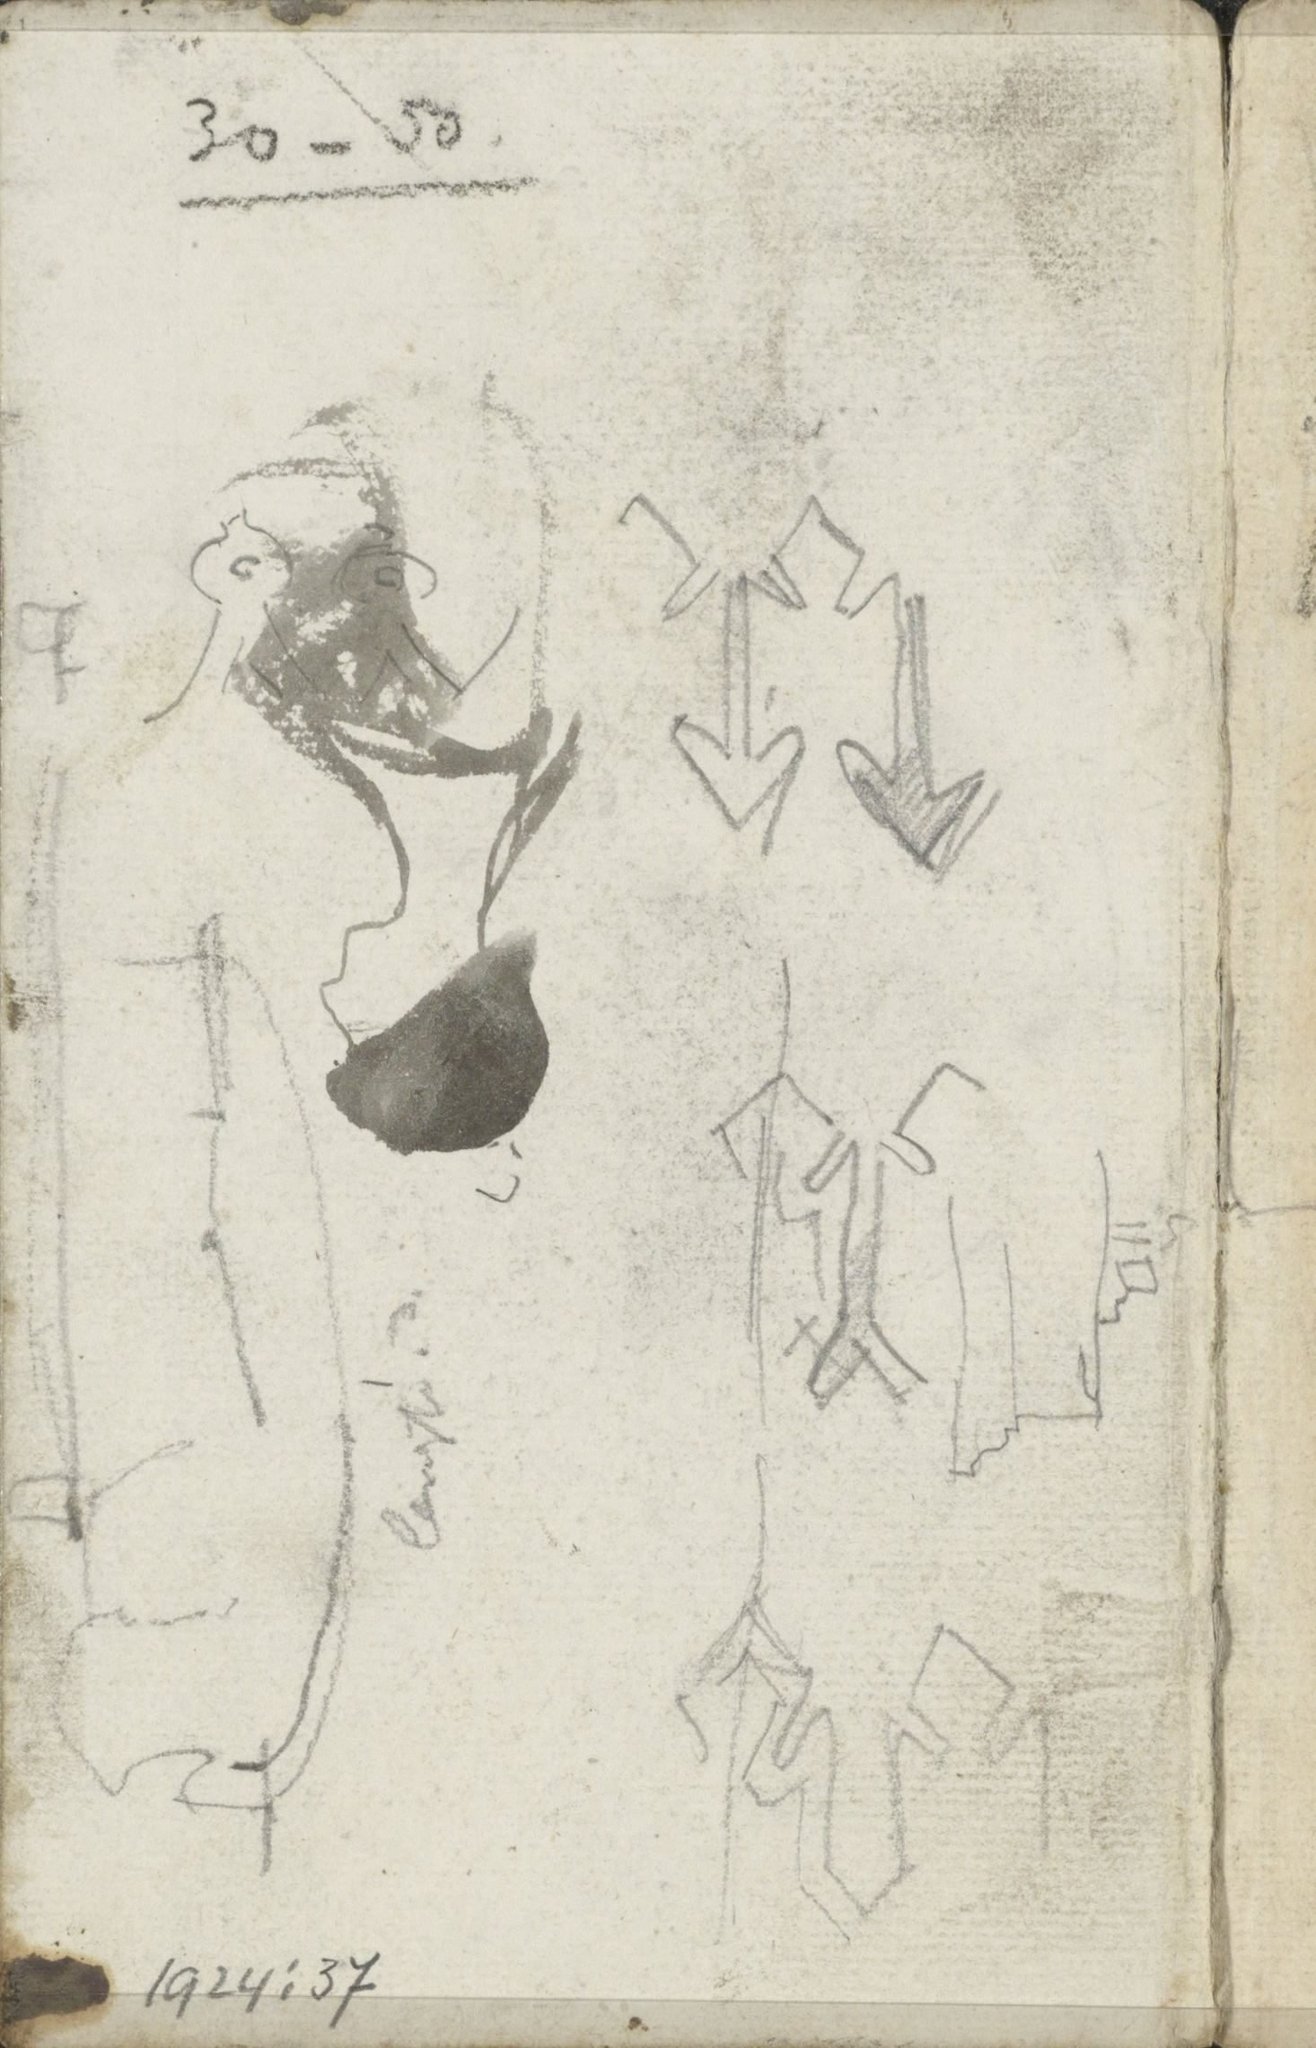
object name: endleaf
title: Architectuurstudies en een vrouw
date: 1880-1882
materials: paper, pencil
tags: architectural detail, adult woman (+ sideview, profile)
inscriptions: annotation: ‘30-50/ lengte!’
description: Pagina 1, voorste schutblad, uit een schetsboek met 31 bladen.